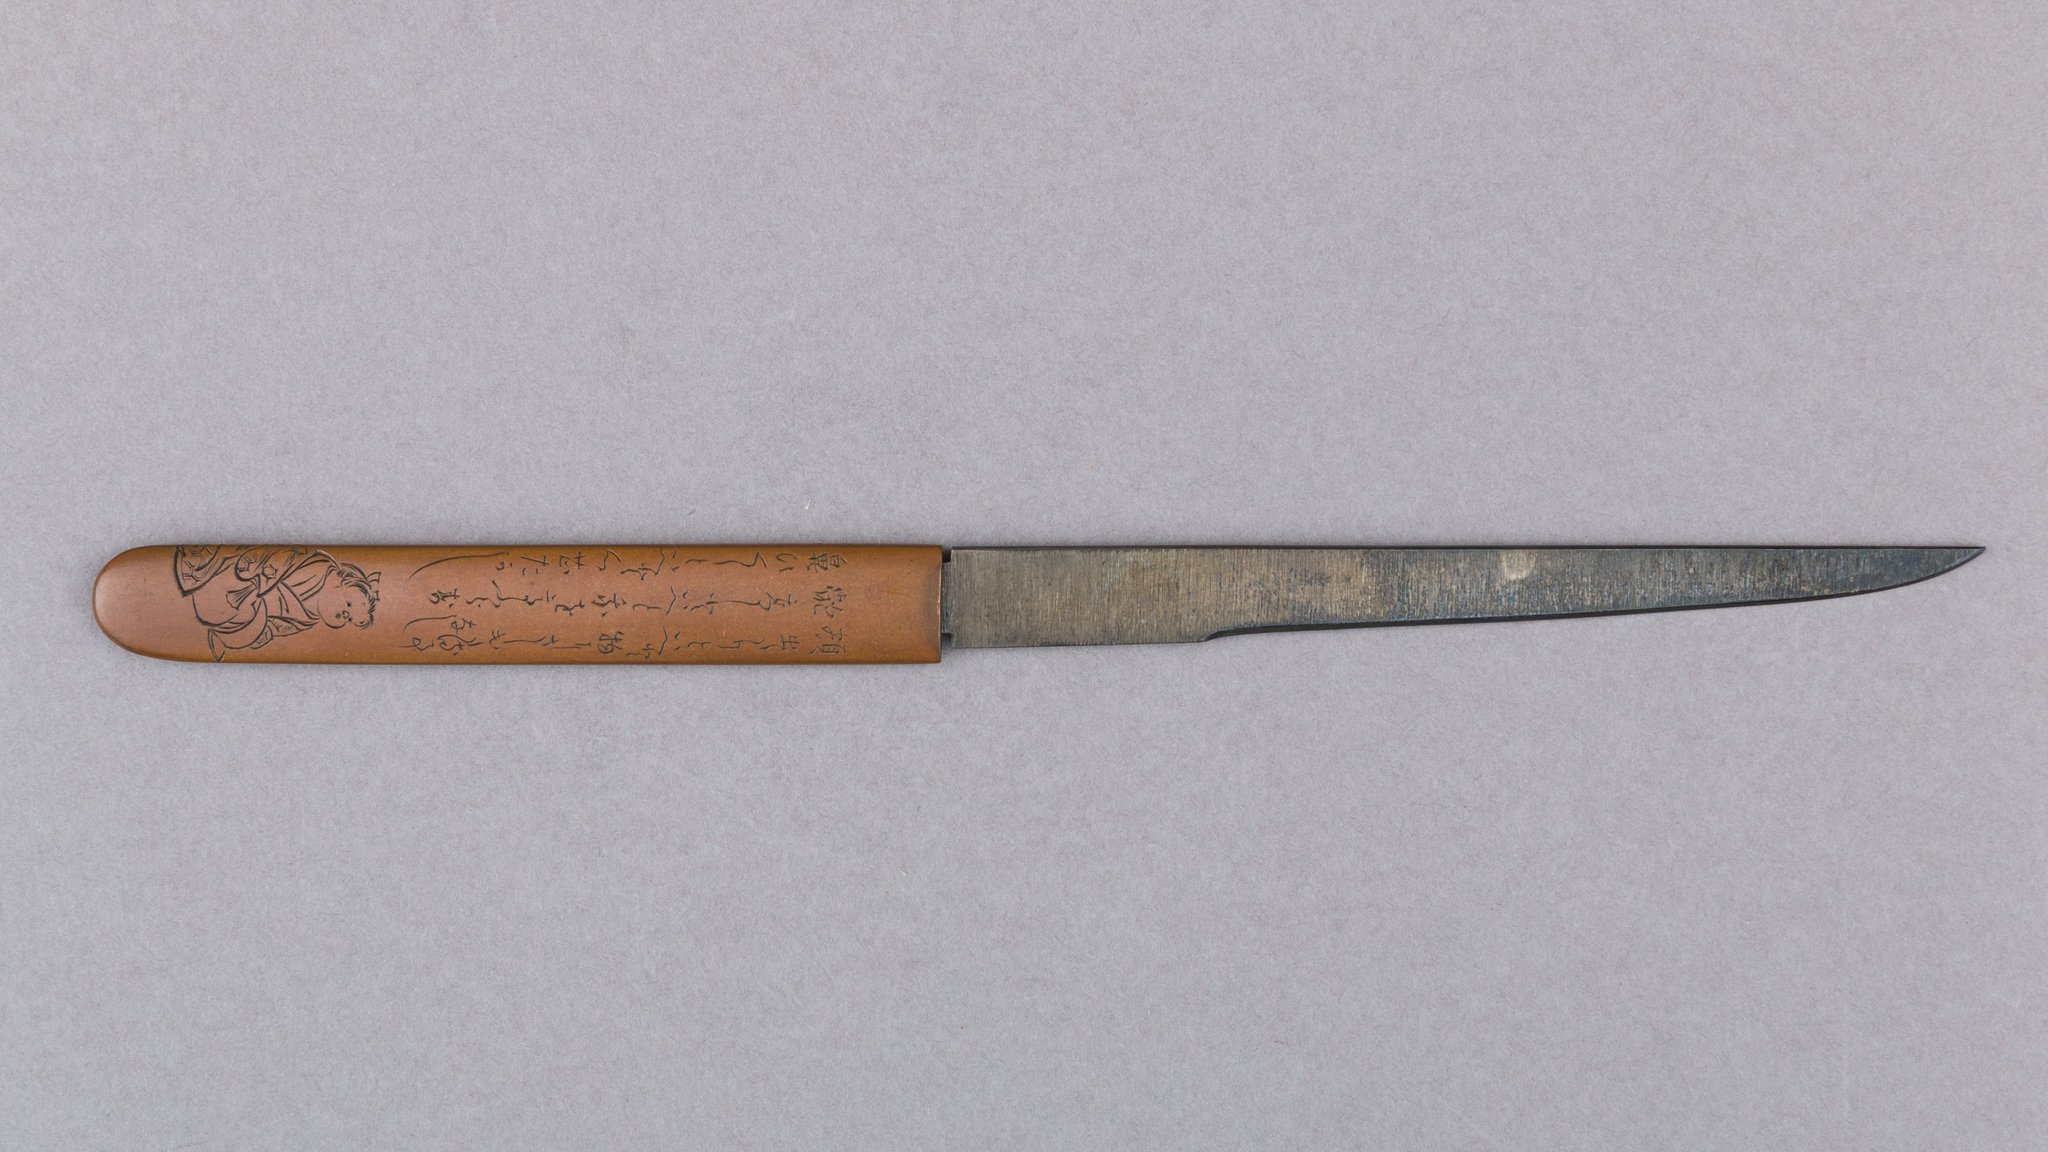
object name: knife handle kozuka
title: Knife Handle (Kozuka) with Blade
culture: japanese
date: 1801-1900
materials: copper, steel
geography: japan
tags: human figures